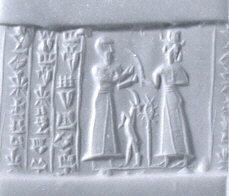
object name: cylinder seal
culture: elamite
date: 1800-1601 BCE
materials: mineral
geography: iran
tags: animals,men